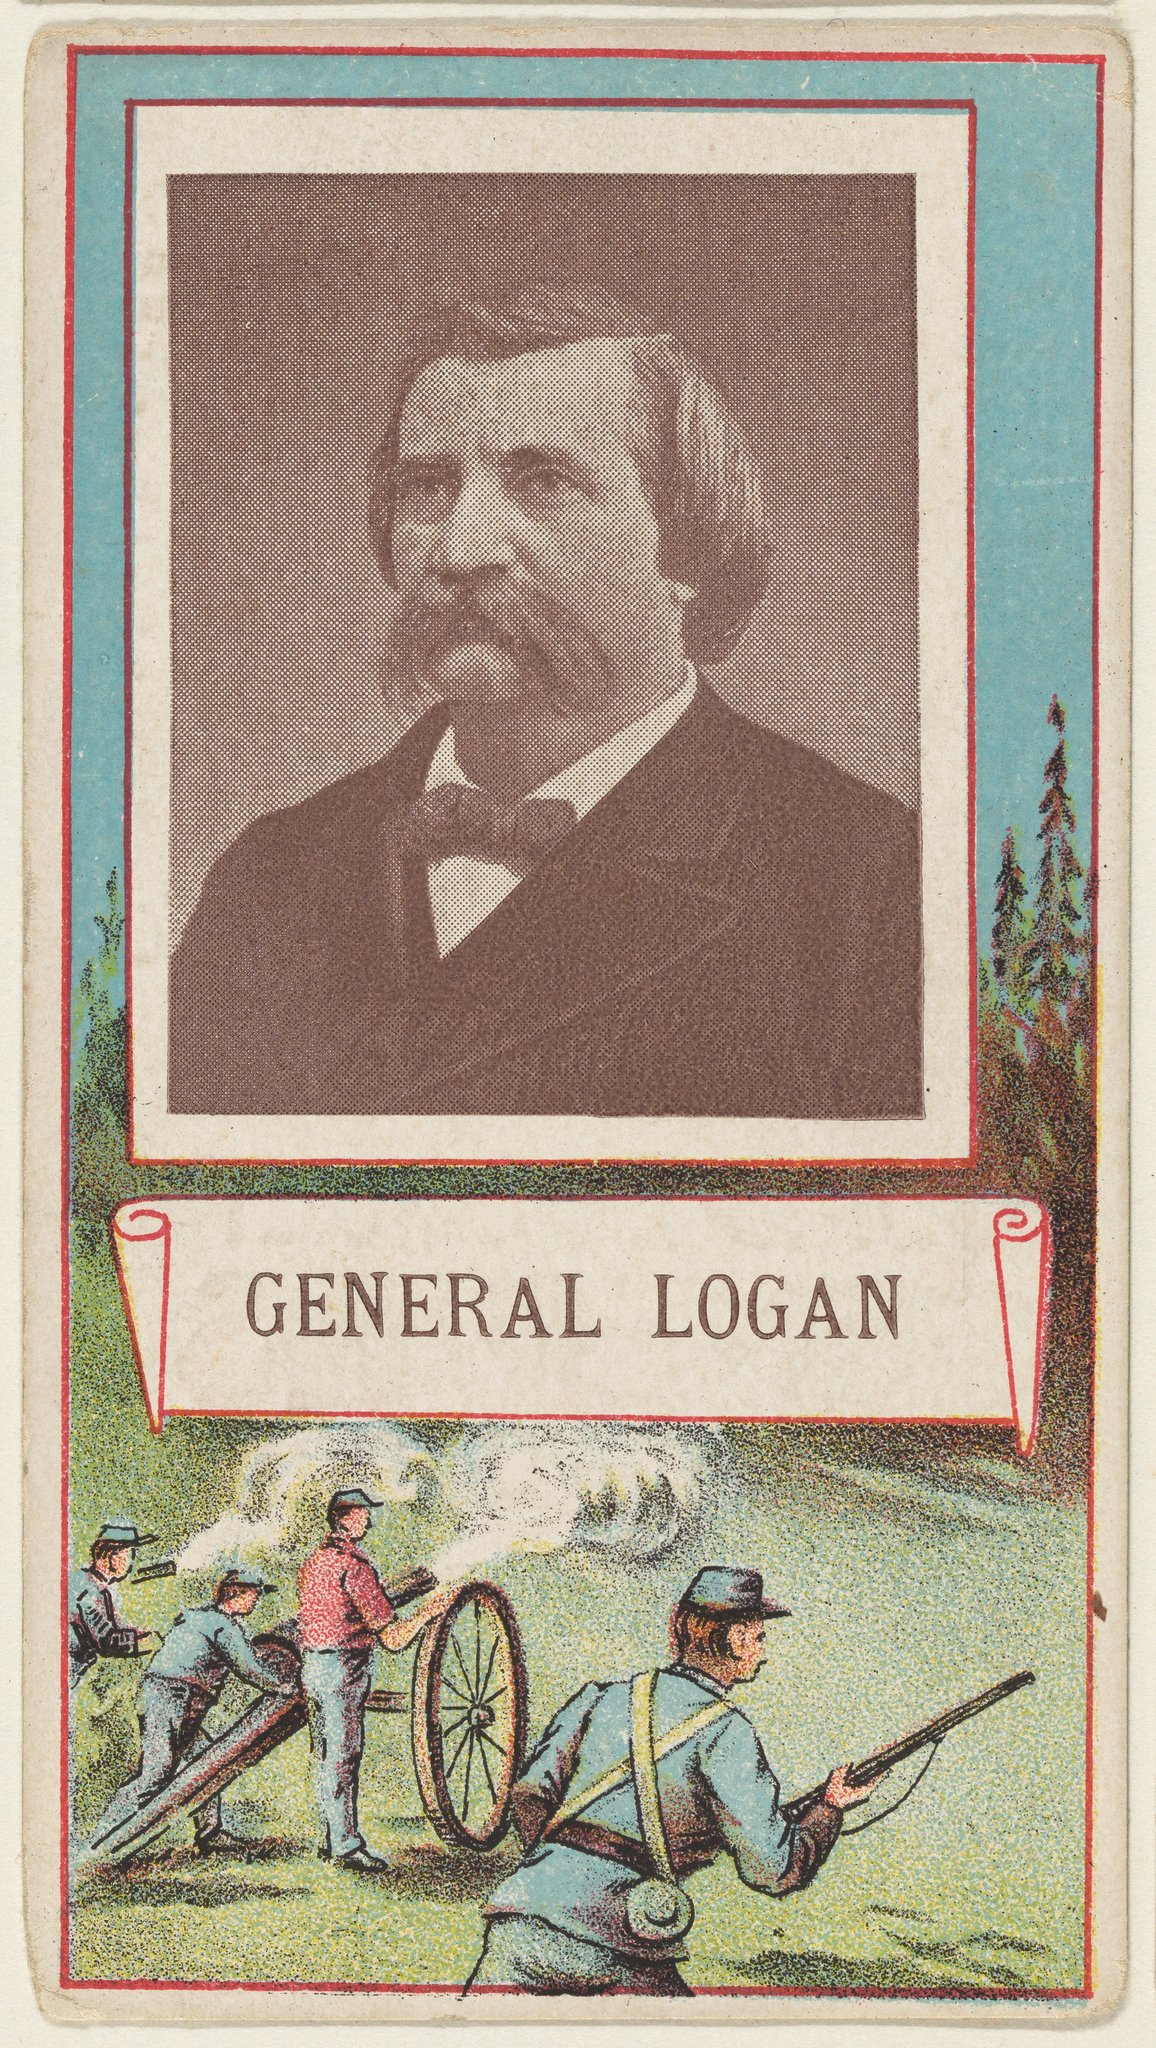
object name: print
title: General Logan, from the "Generals" series (T64), issued by D.H. McAlpin & Co. Tobacco Company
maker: d.h. mcalpin & co. tobacco company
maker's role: publisher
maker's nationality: american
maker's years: 1857-1901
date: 1901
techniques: color lithograph